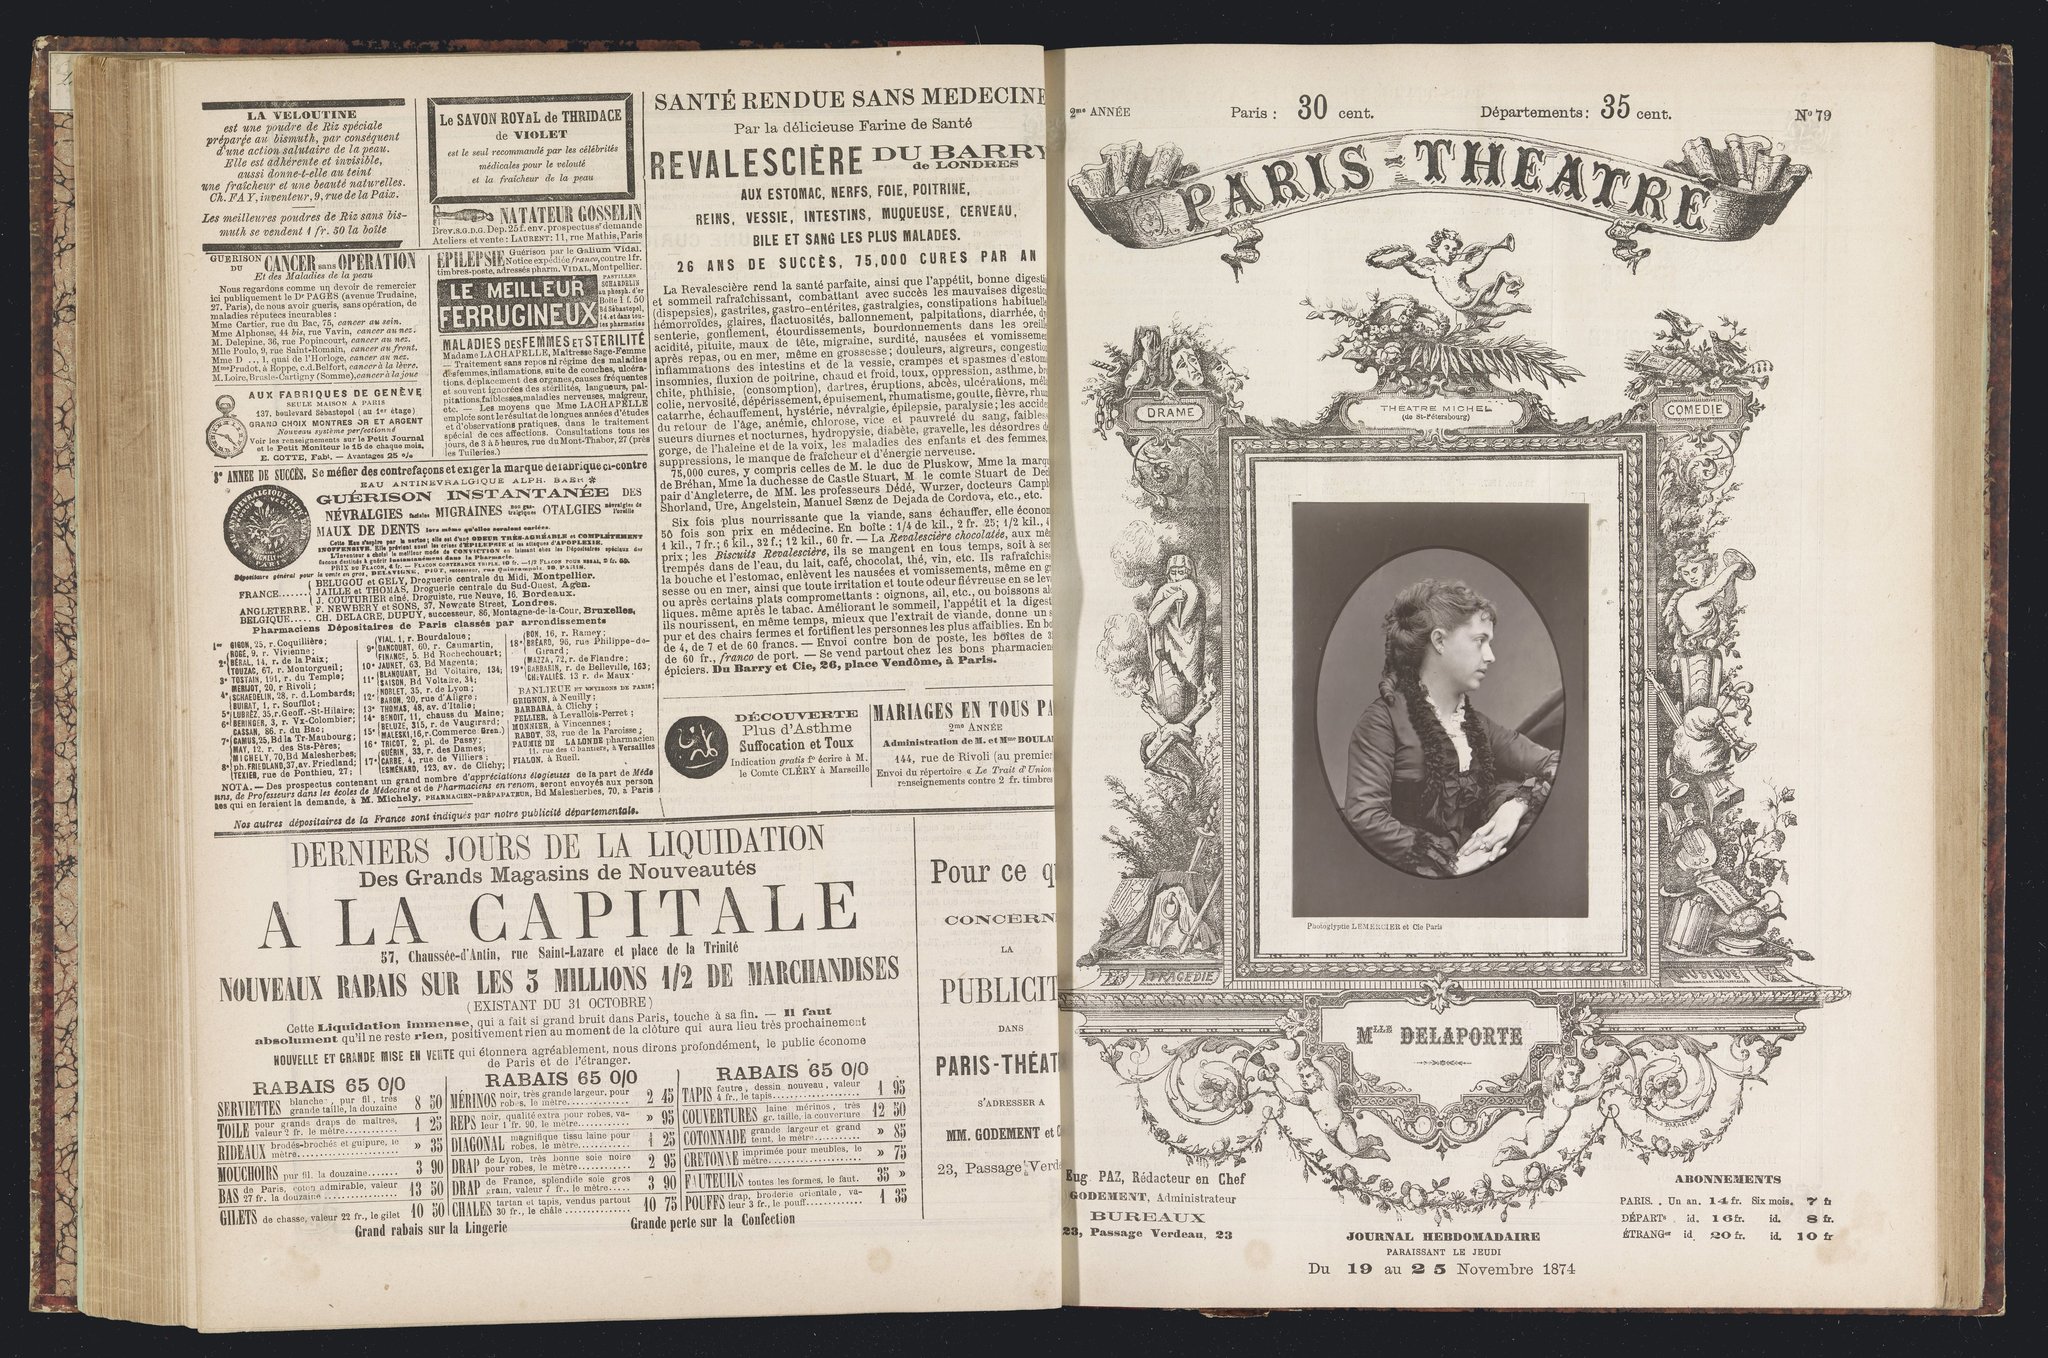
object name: page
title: Portret van Marie Delaporte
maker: Anonymous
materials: paper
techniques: woodburytype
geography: france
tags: portrait of actor, actress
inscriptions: number: ‘No 79’, inscription: ‘Journal hebdomadaire paraissant le jeudi Du 19 au 25 Novembre 1874’